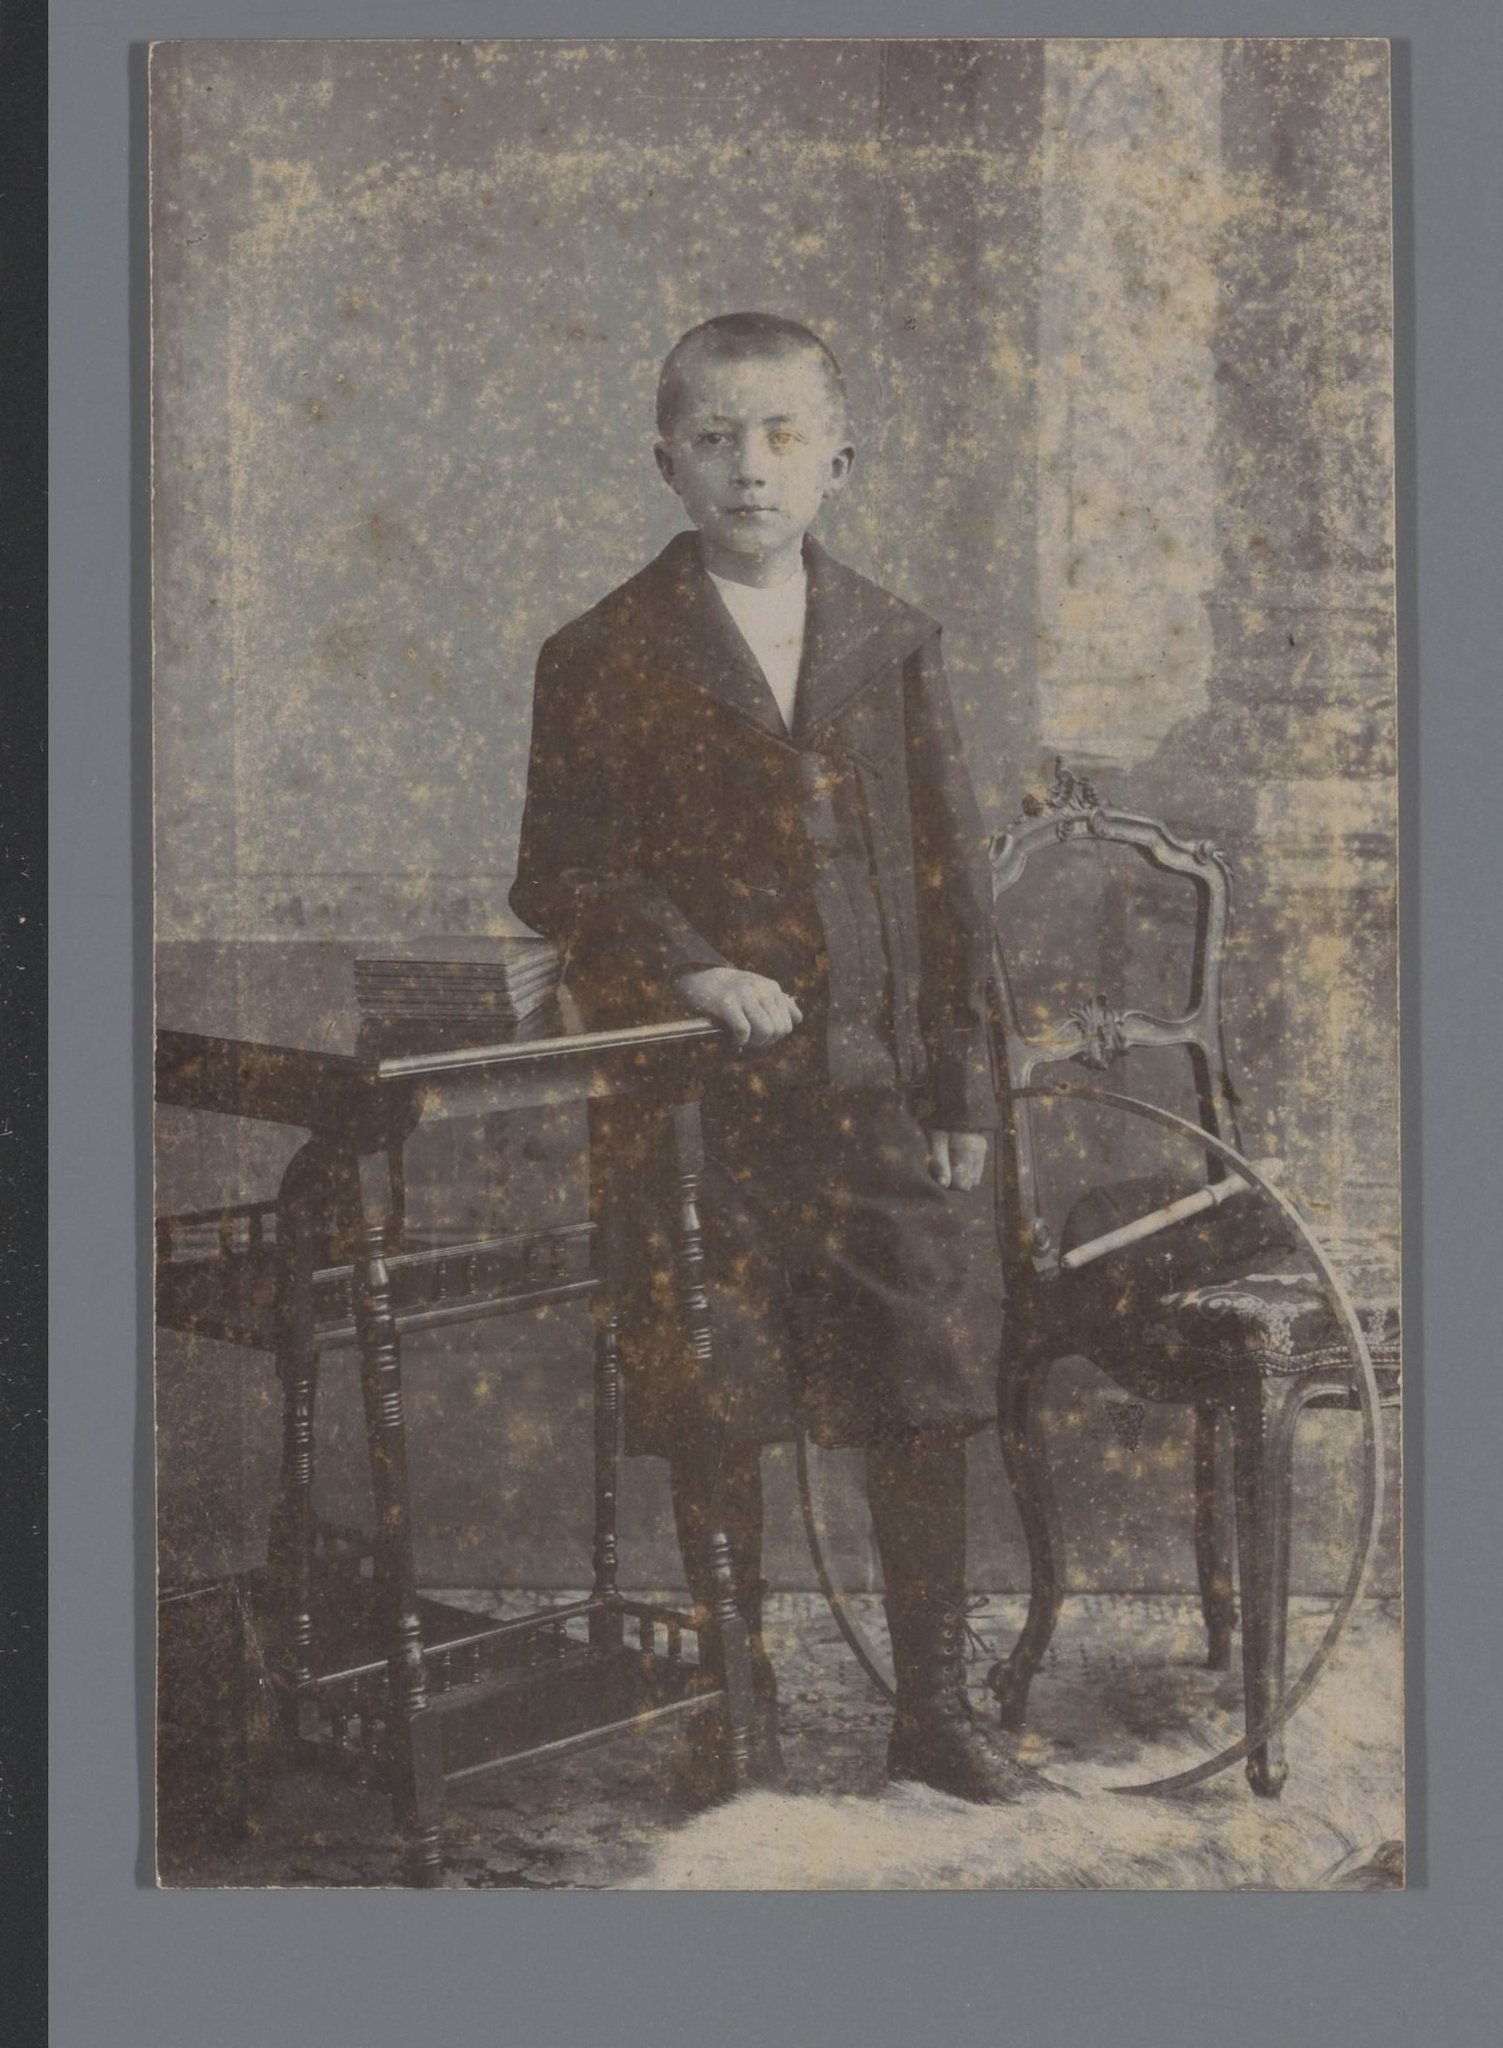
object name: photograph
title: Portret van een onbekende jongen in een interieur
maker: Anonymous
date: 1900-1915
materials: photographic support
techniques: gelatin silver print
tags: youth, adolescent, interior ~ representation of a building